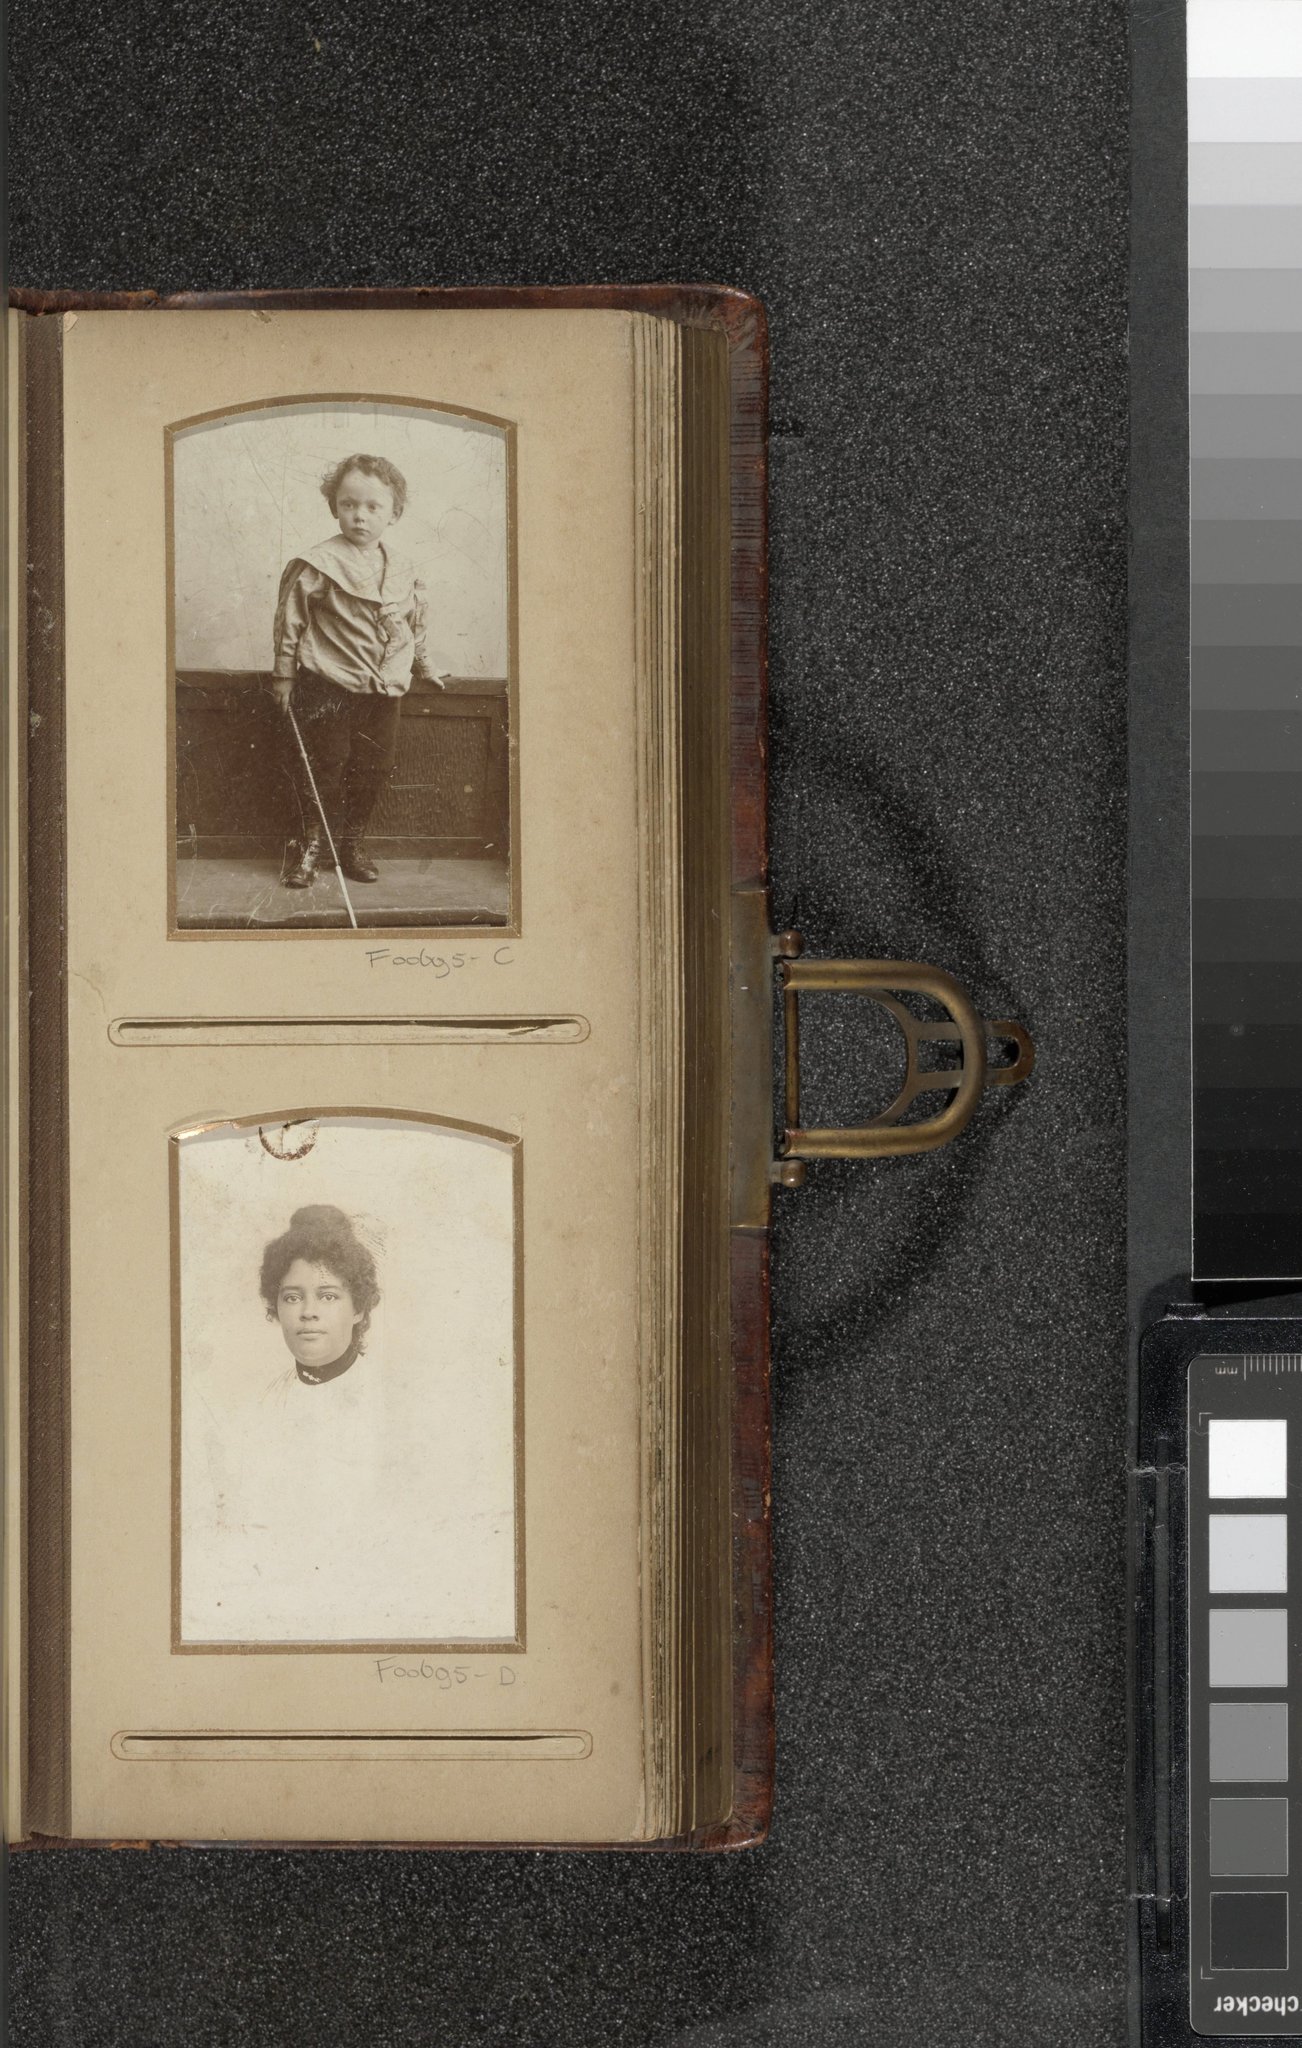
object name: carte de visite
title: Portret van (vermoedelijk) een Surinaamse vrouw aangeduid als Marie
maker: eugen klein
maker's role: fotograaf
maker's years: 1869-1927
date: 1890-1915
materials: cardboard, paper, photographic support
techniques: gelatin silver print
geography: paramaribo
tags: adult woman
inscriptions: inscription: ‘Marie’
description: Onderdeel van Album met 28 foto's van een Nederlands-Surinaamse familie.